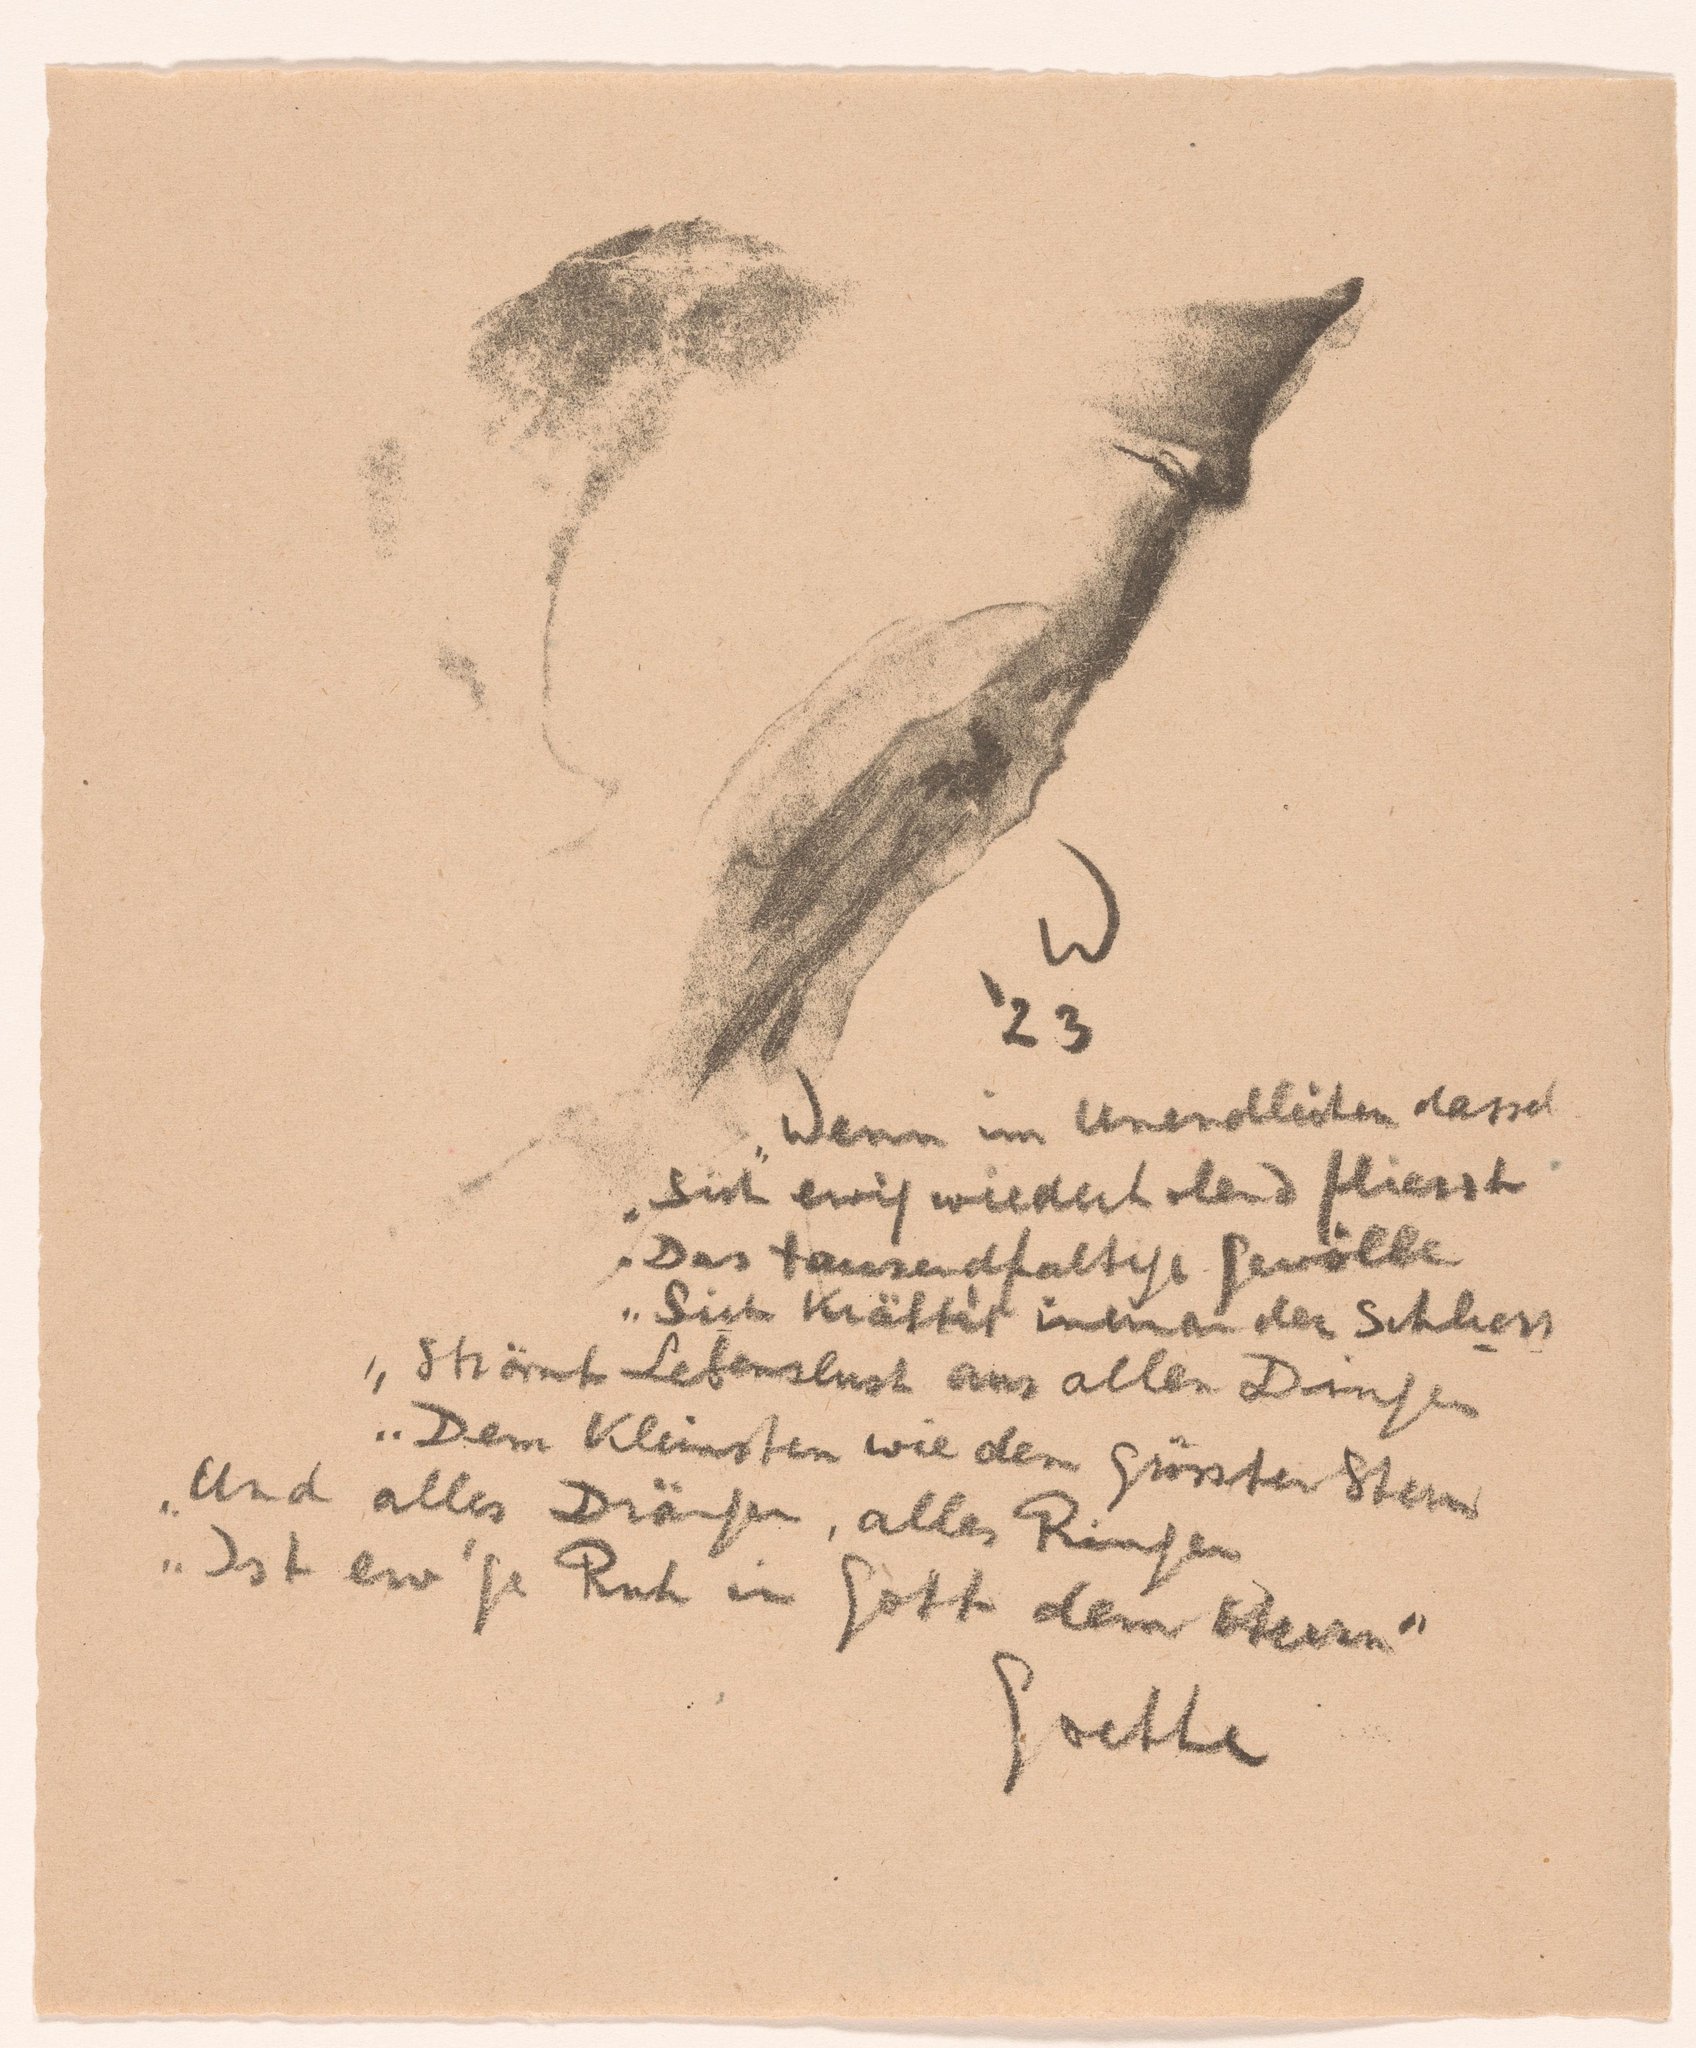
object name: poem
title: Abstracte compositie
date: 1923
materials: paper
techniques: lithograph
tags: draughtsman, johann wolfgang von goethe, abstract, non-representational art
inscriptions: collector's mark: Lugt 2228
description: Onderaan het gedicht 'Wenn im Unendlichen dasselbe' van Johann Wolfgang von Goethe.